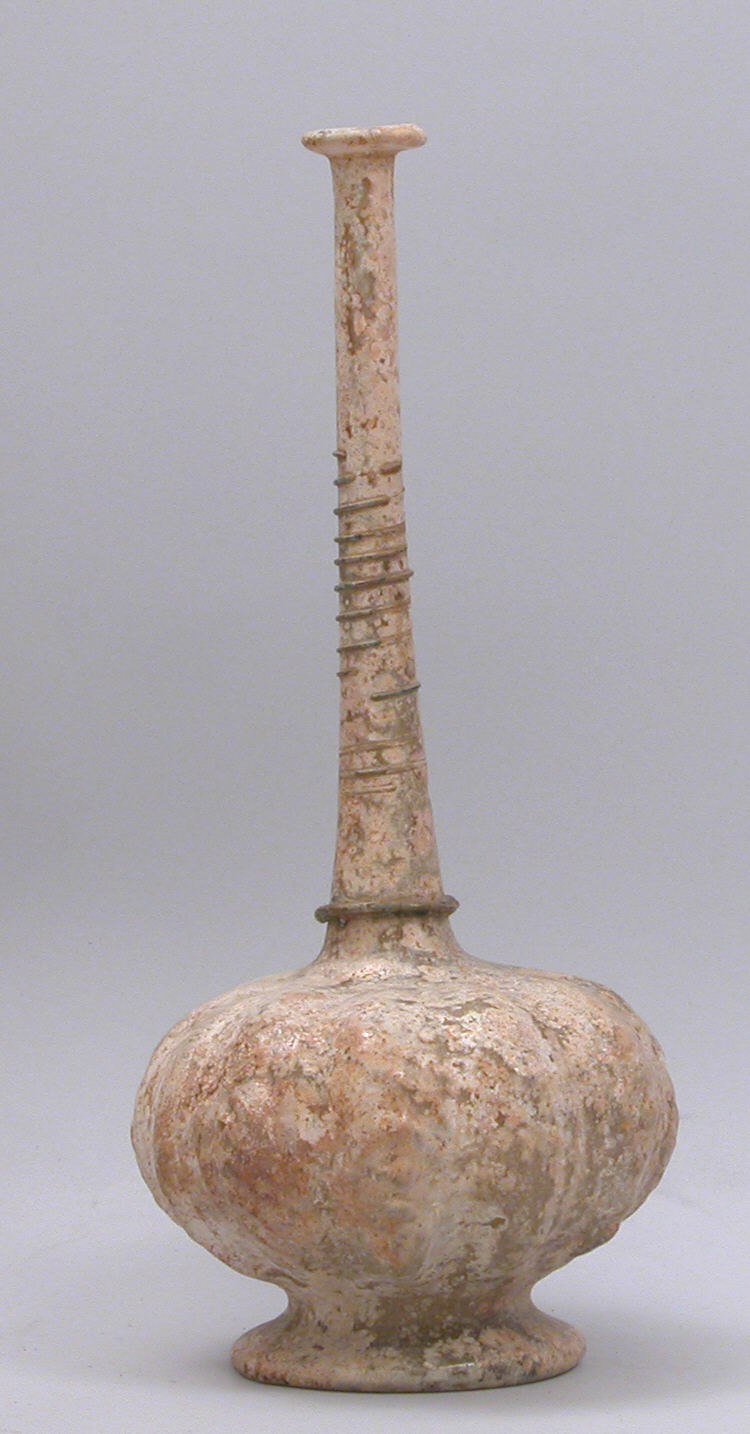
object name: bottle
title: Bottle with Applied Decoration on the Neck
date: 1001-1300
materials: glass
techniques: glassblowing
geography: iran